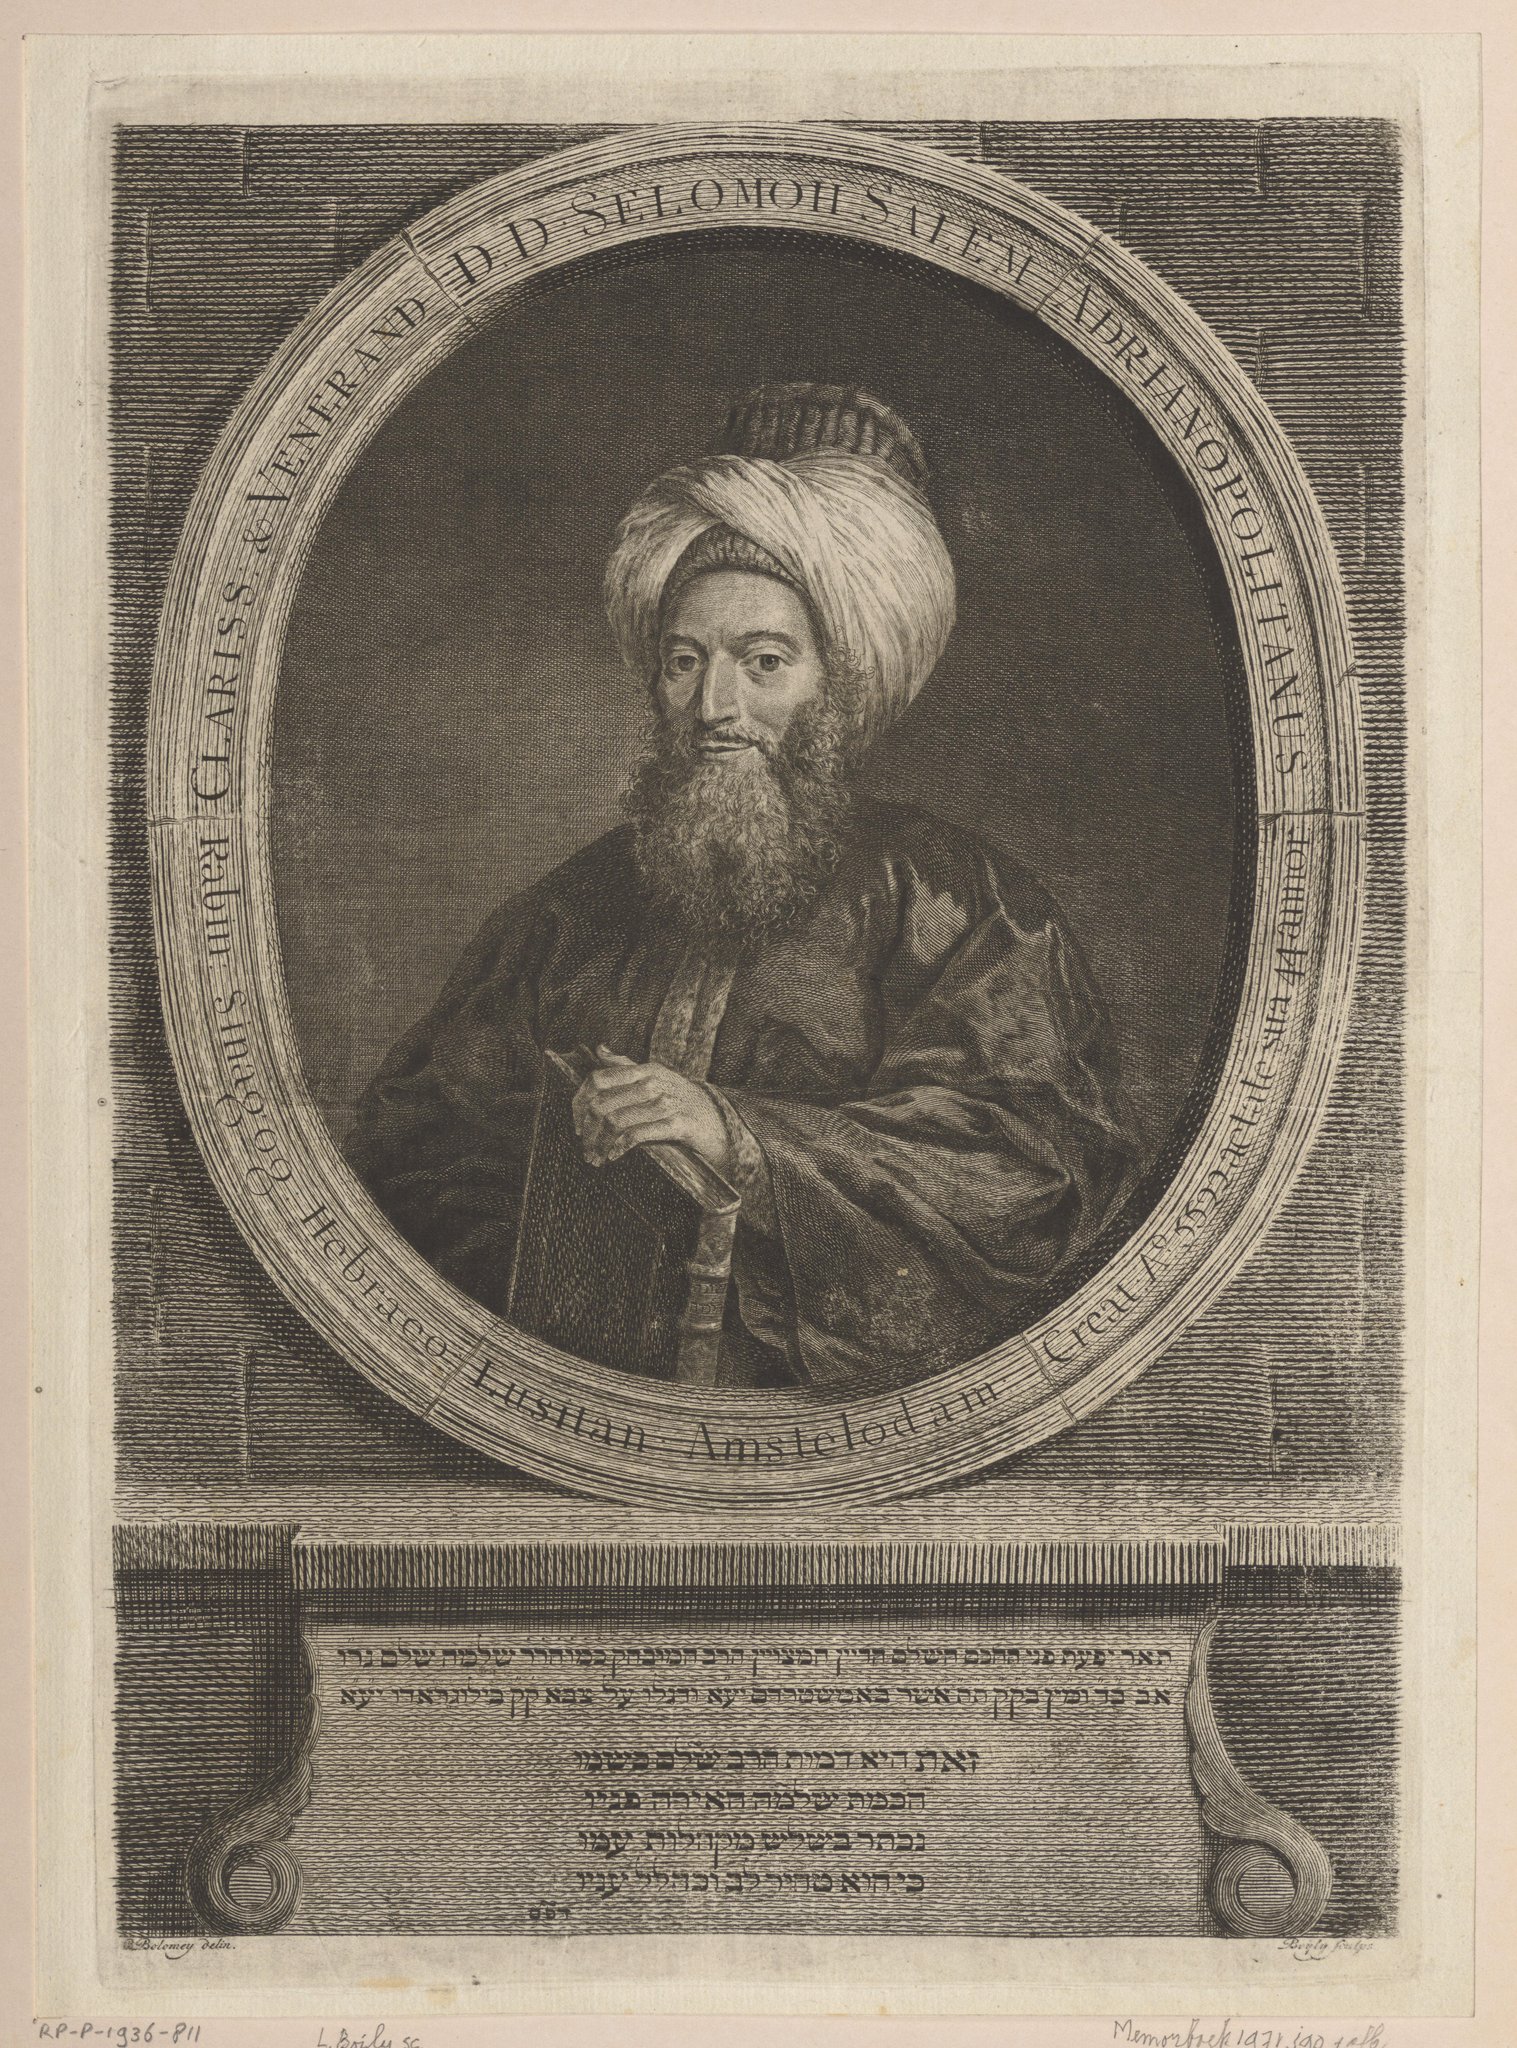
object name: print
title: Portret van Selomoh Salem op 44-jarige leeftijd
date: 1762-1813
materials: paper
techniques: engraving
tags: historical persons, chief rabbi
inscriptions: collector's mark: Lugt 2228, collector's mark: Lugt 2760